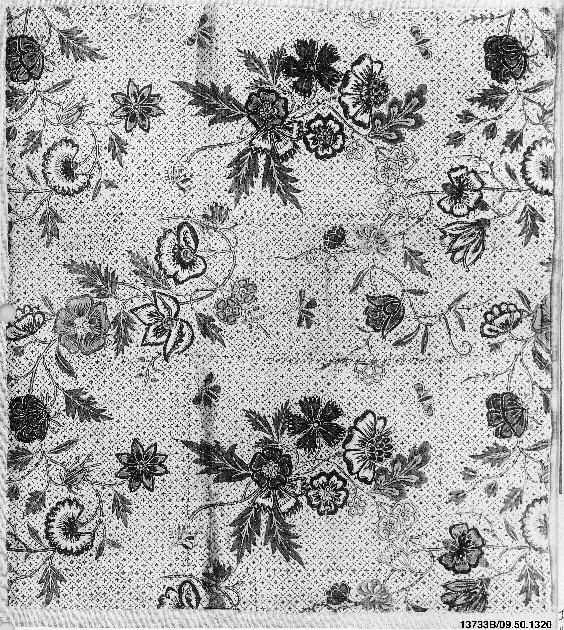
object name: textile fragment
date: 1801-1900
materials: cotton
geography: india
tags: flowers